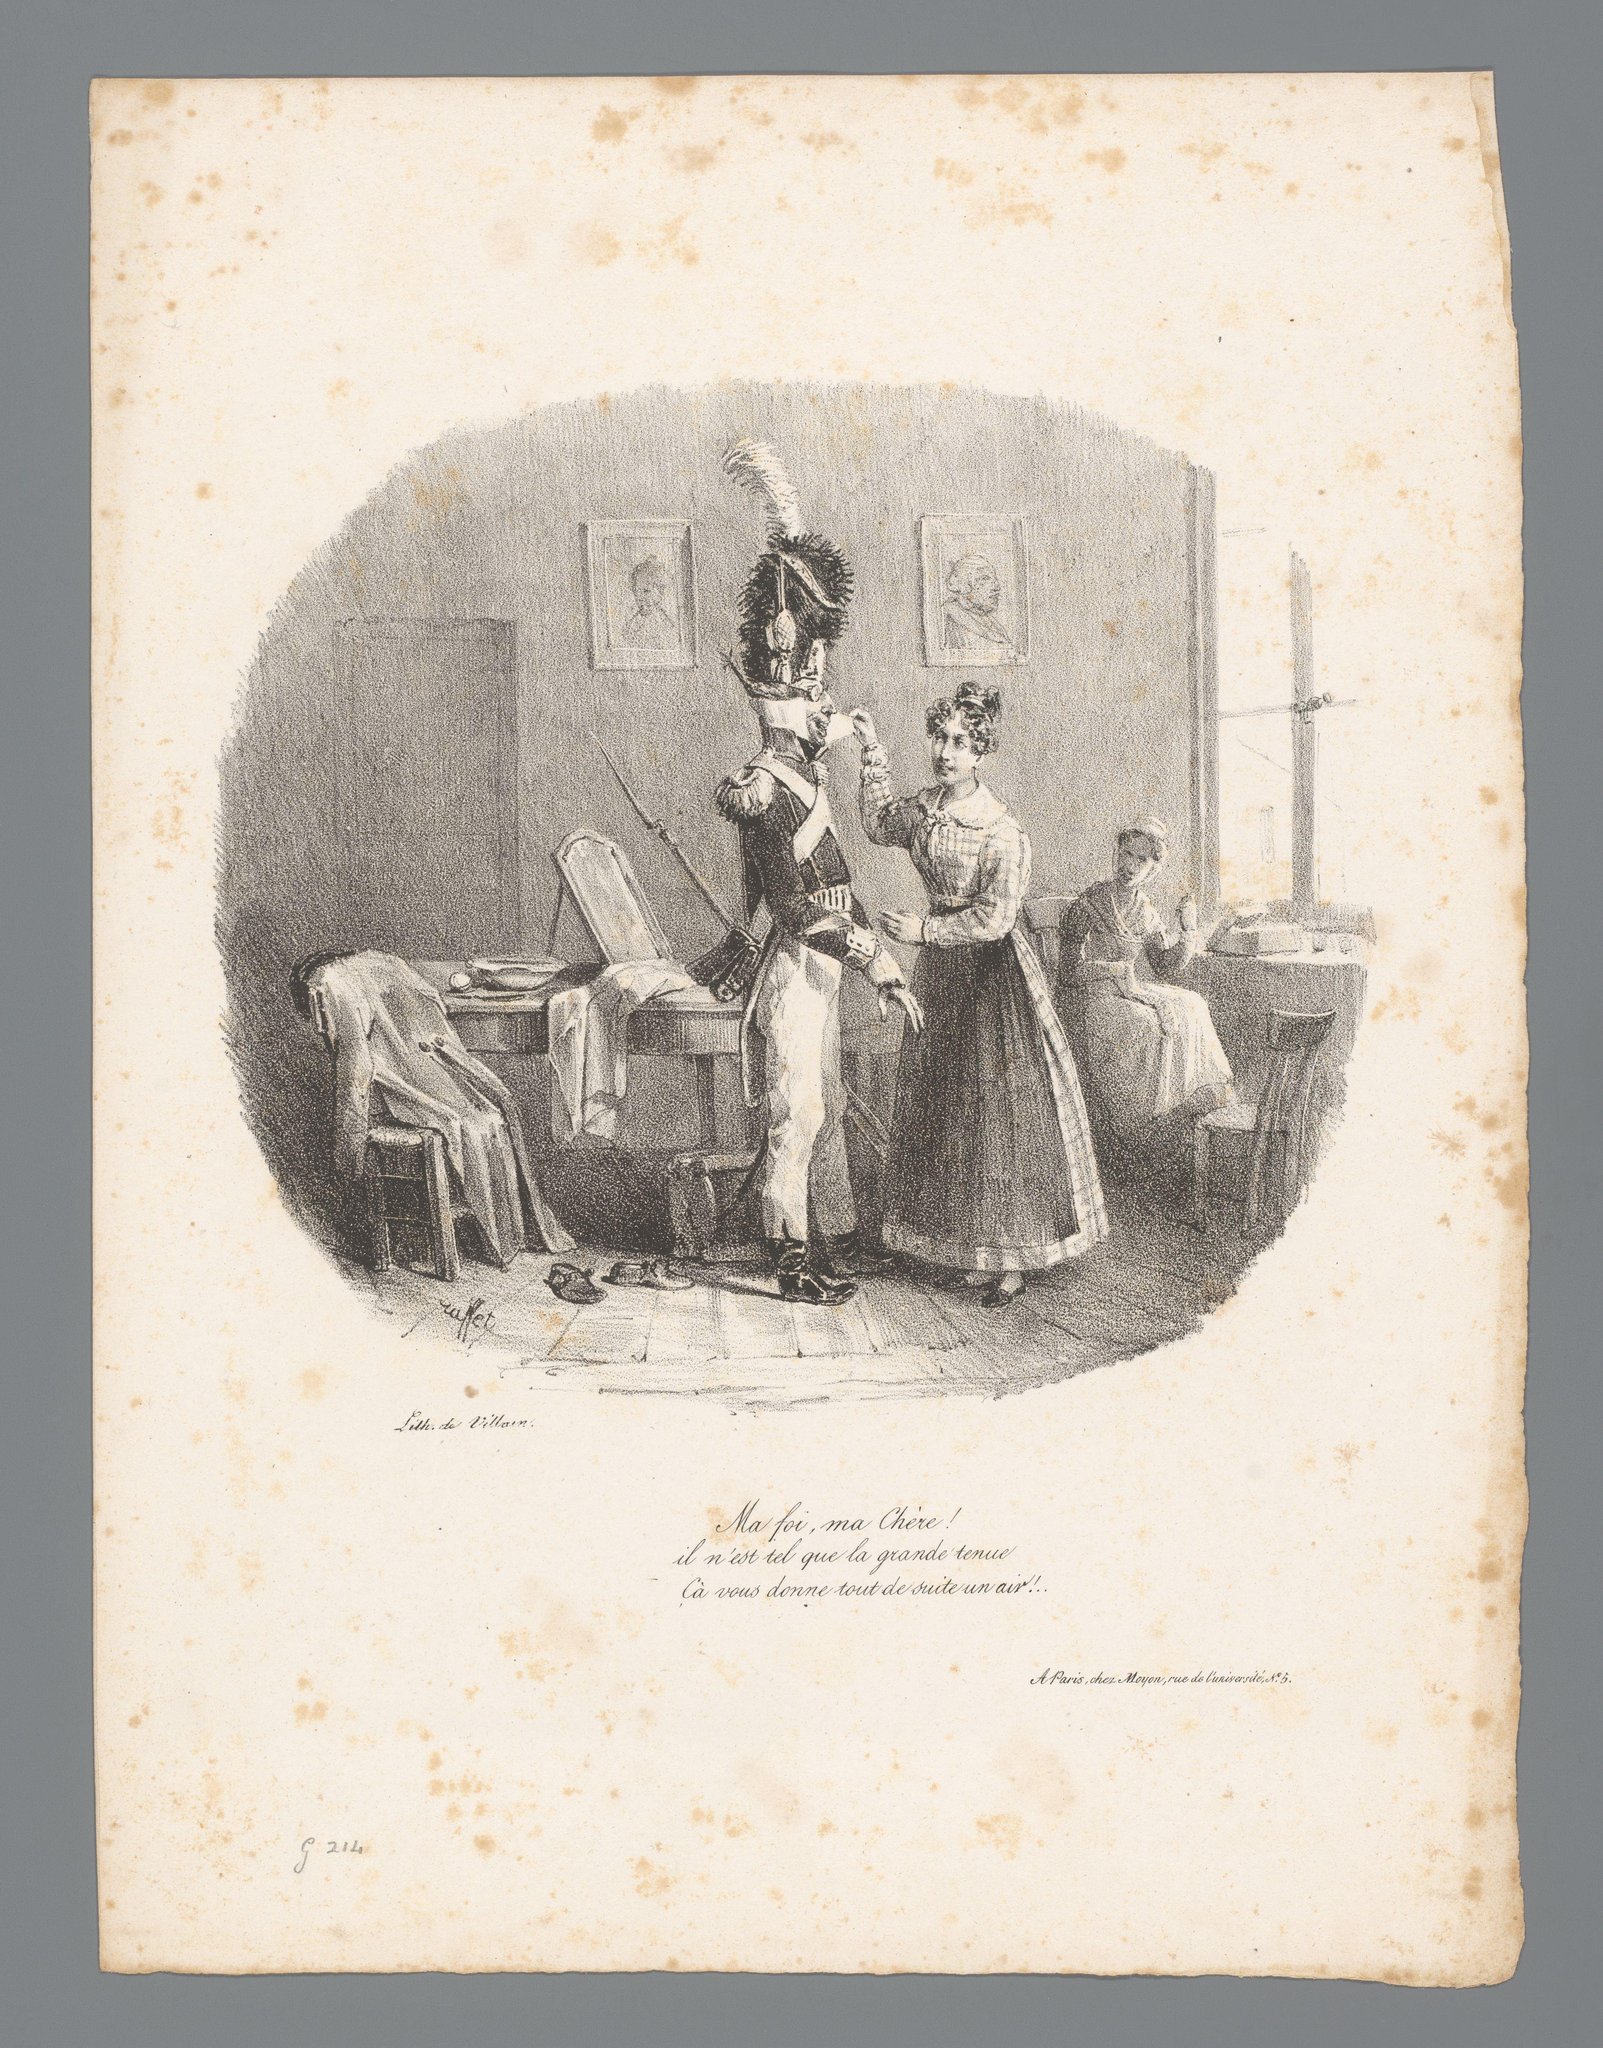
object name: print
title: Twee vrouwen en een soldaat in uniform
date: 1825-1829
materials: paper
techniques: lithograph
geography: paris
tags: adult woman, head-gear, the soldier; the soldier's life, (military) uniforms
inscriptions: collector's mark: Lugt 964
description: Prent mogelijk verschenen in een onbekende serie uitgegeven door Moyon.